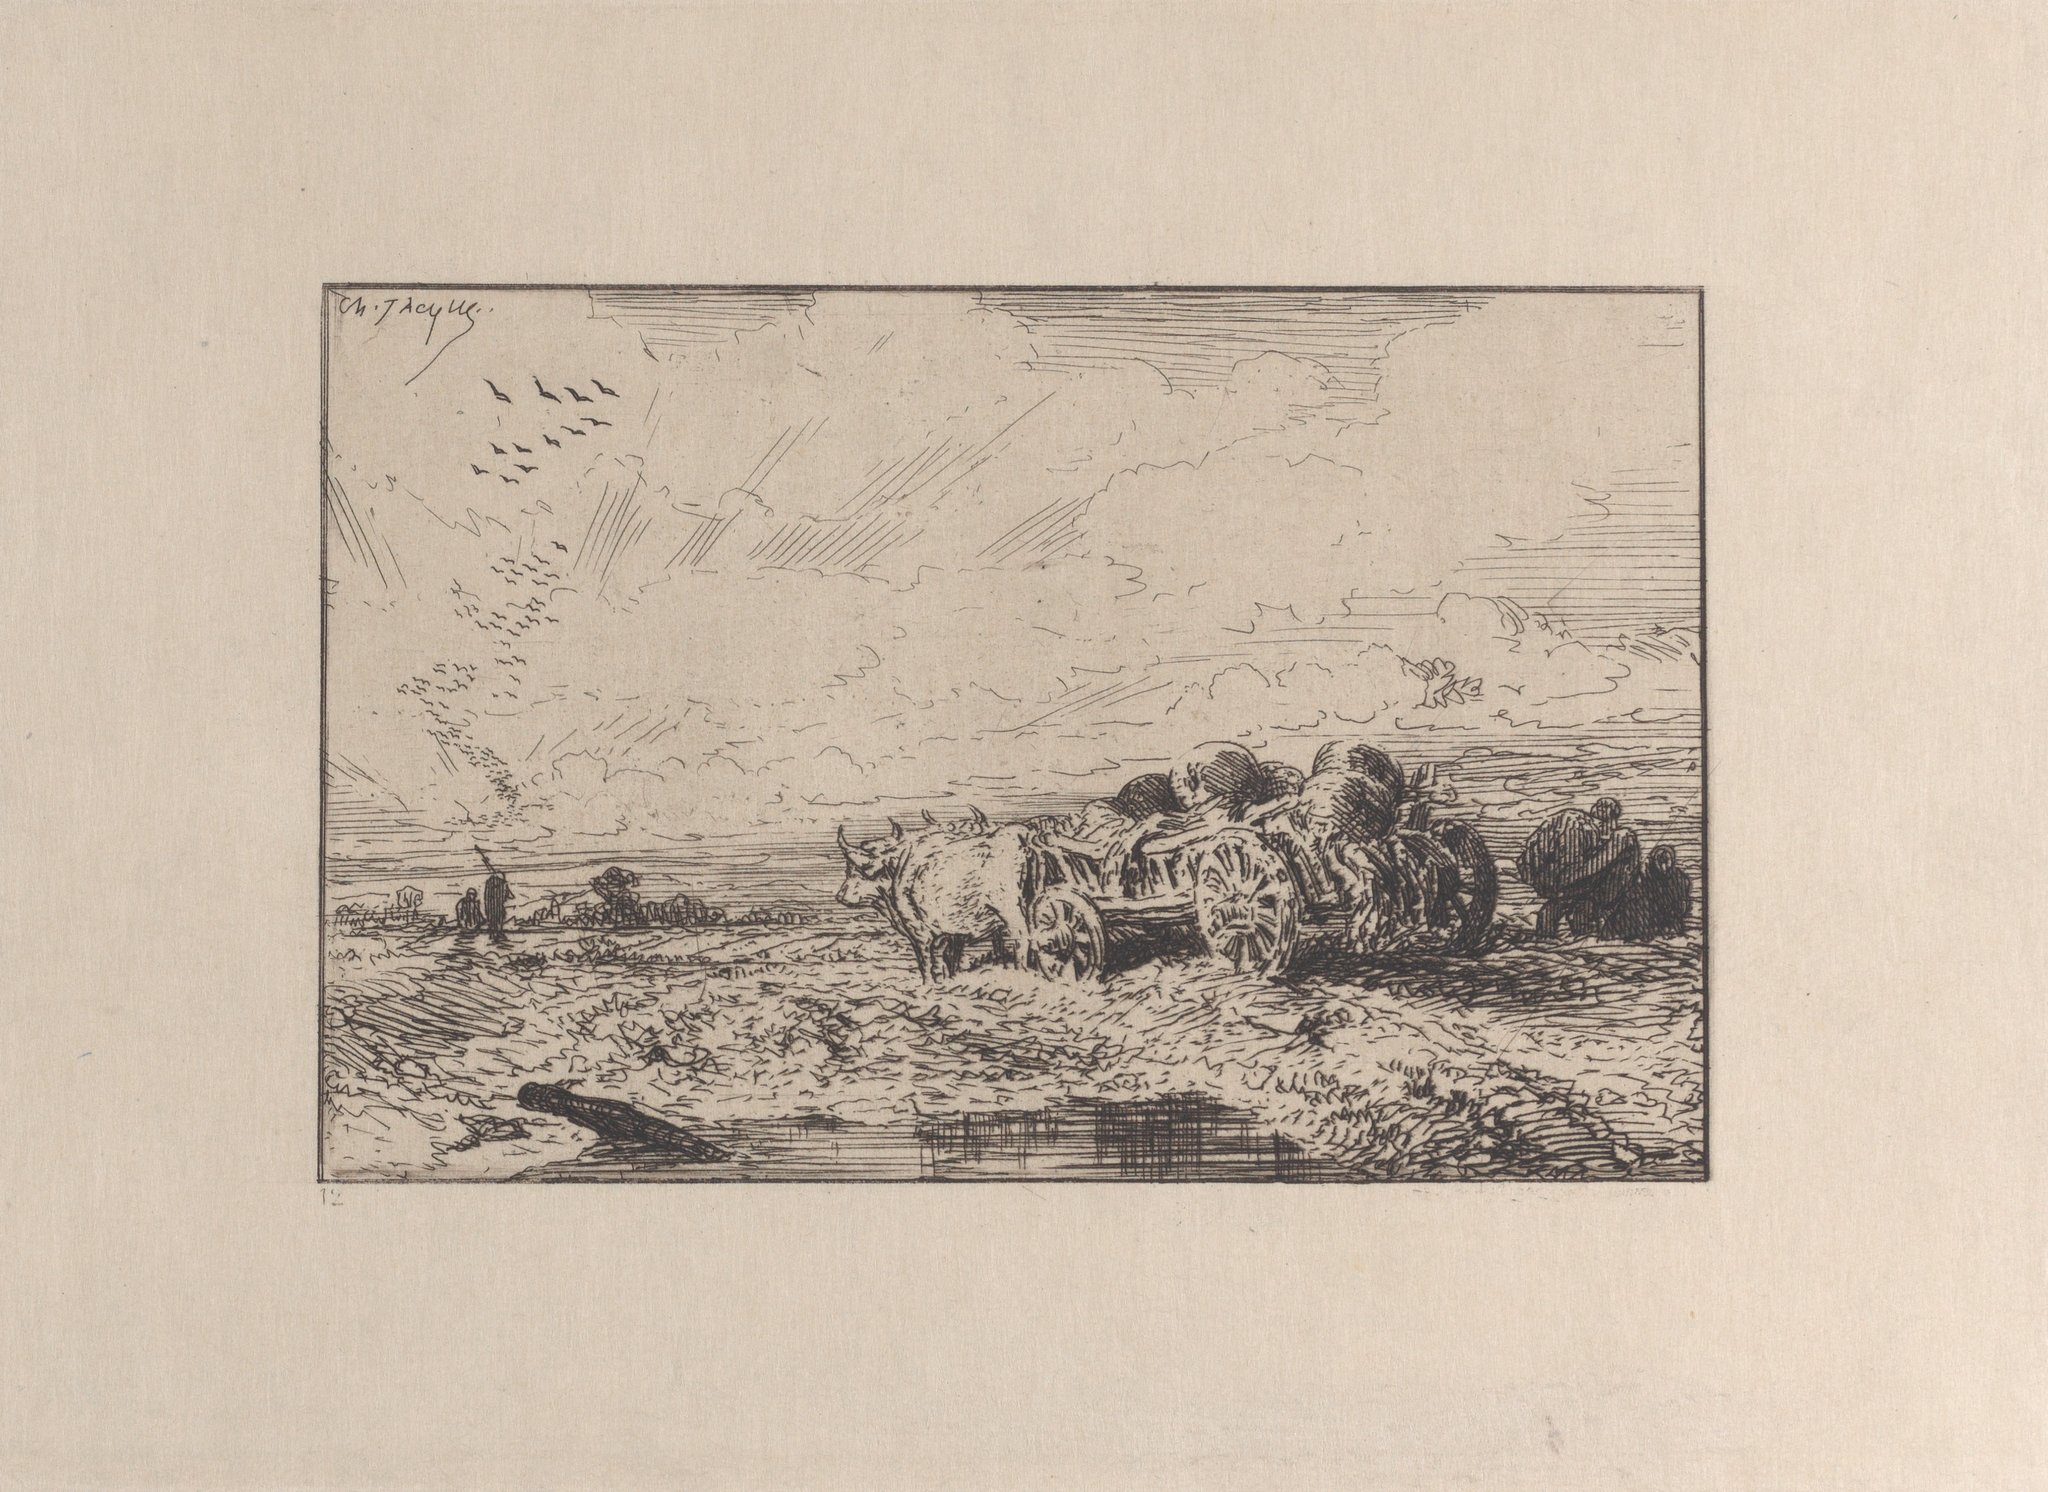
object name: print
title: Landscape with a Cart Pulled by Oxen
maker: charles émile jacque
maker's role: artist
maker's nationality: french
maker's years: 1813-1894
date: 1846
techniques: etching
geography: paris